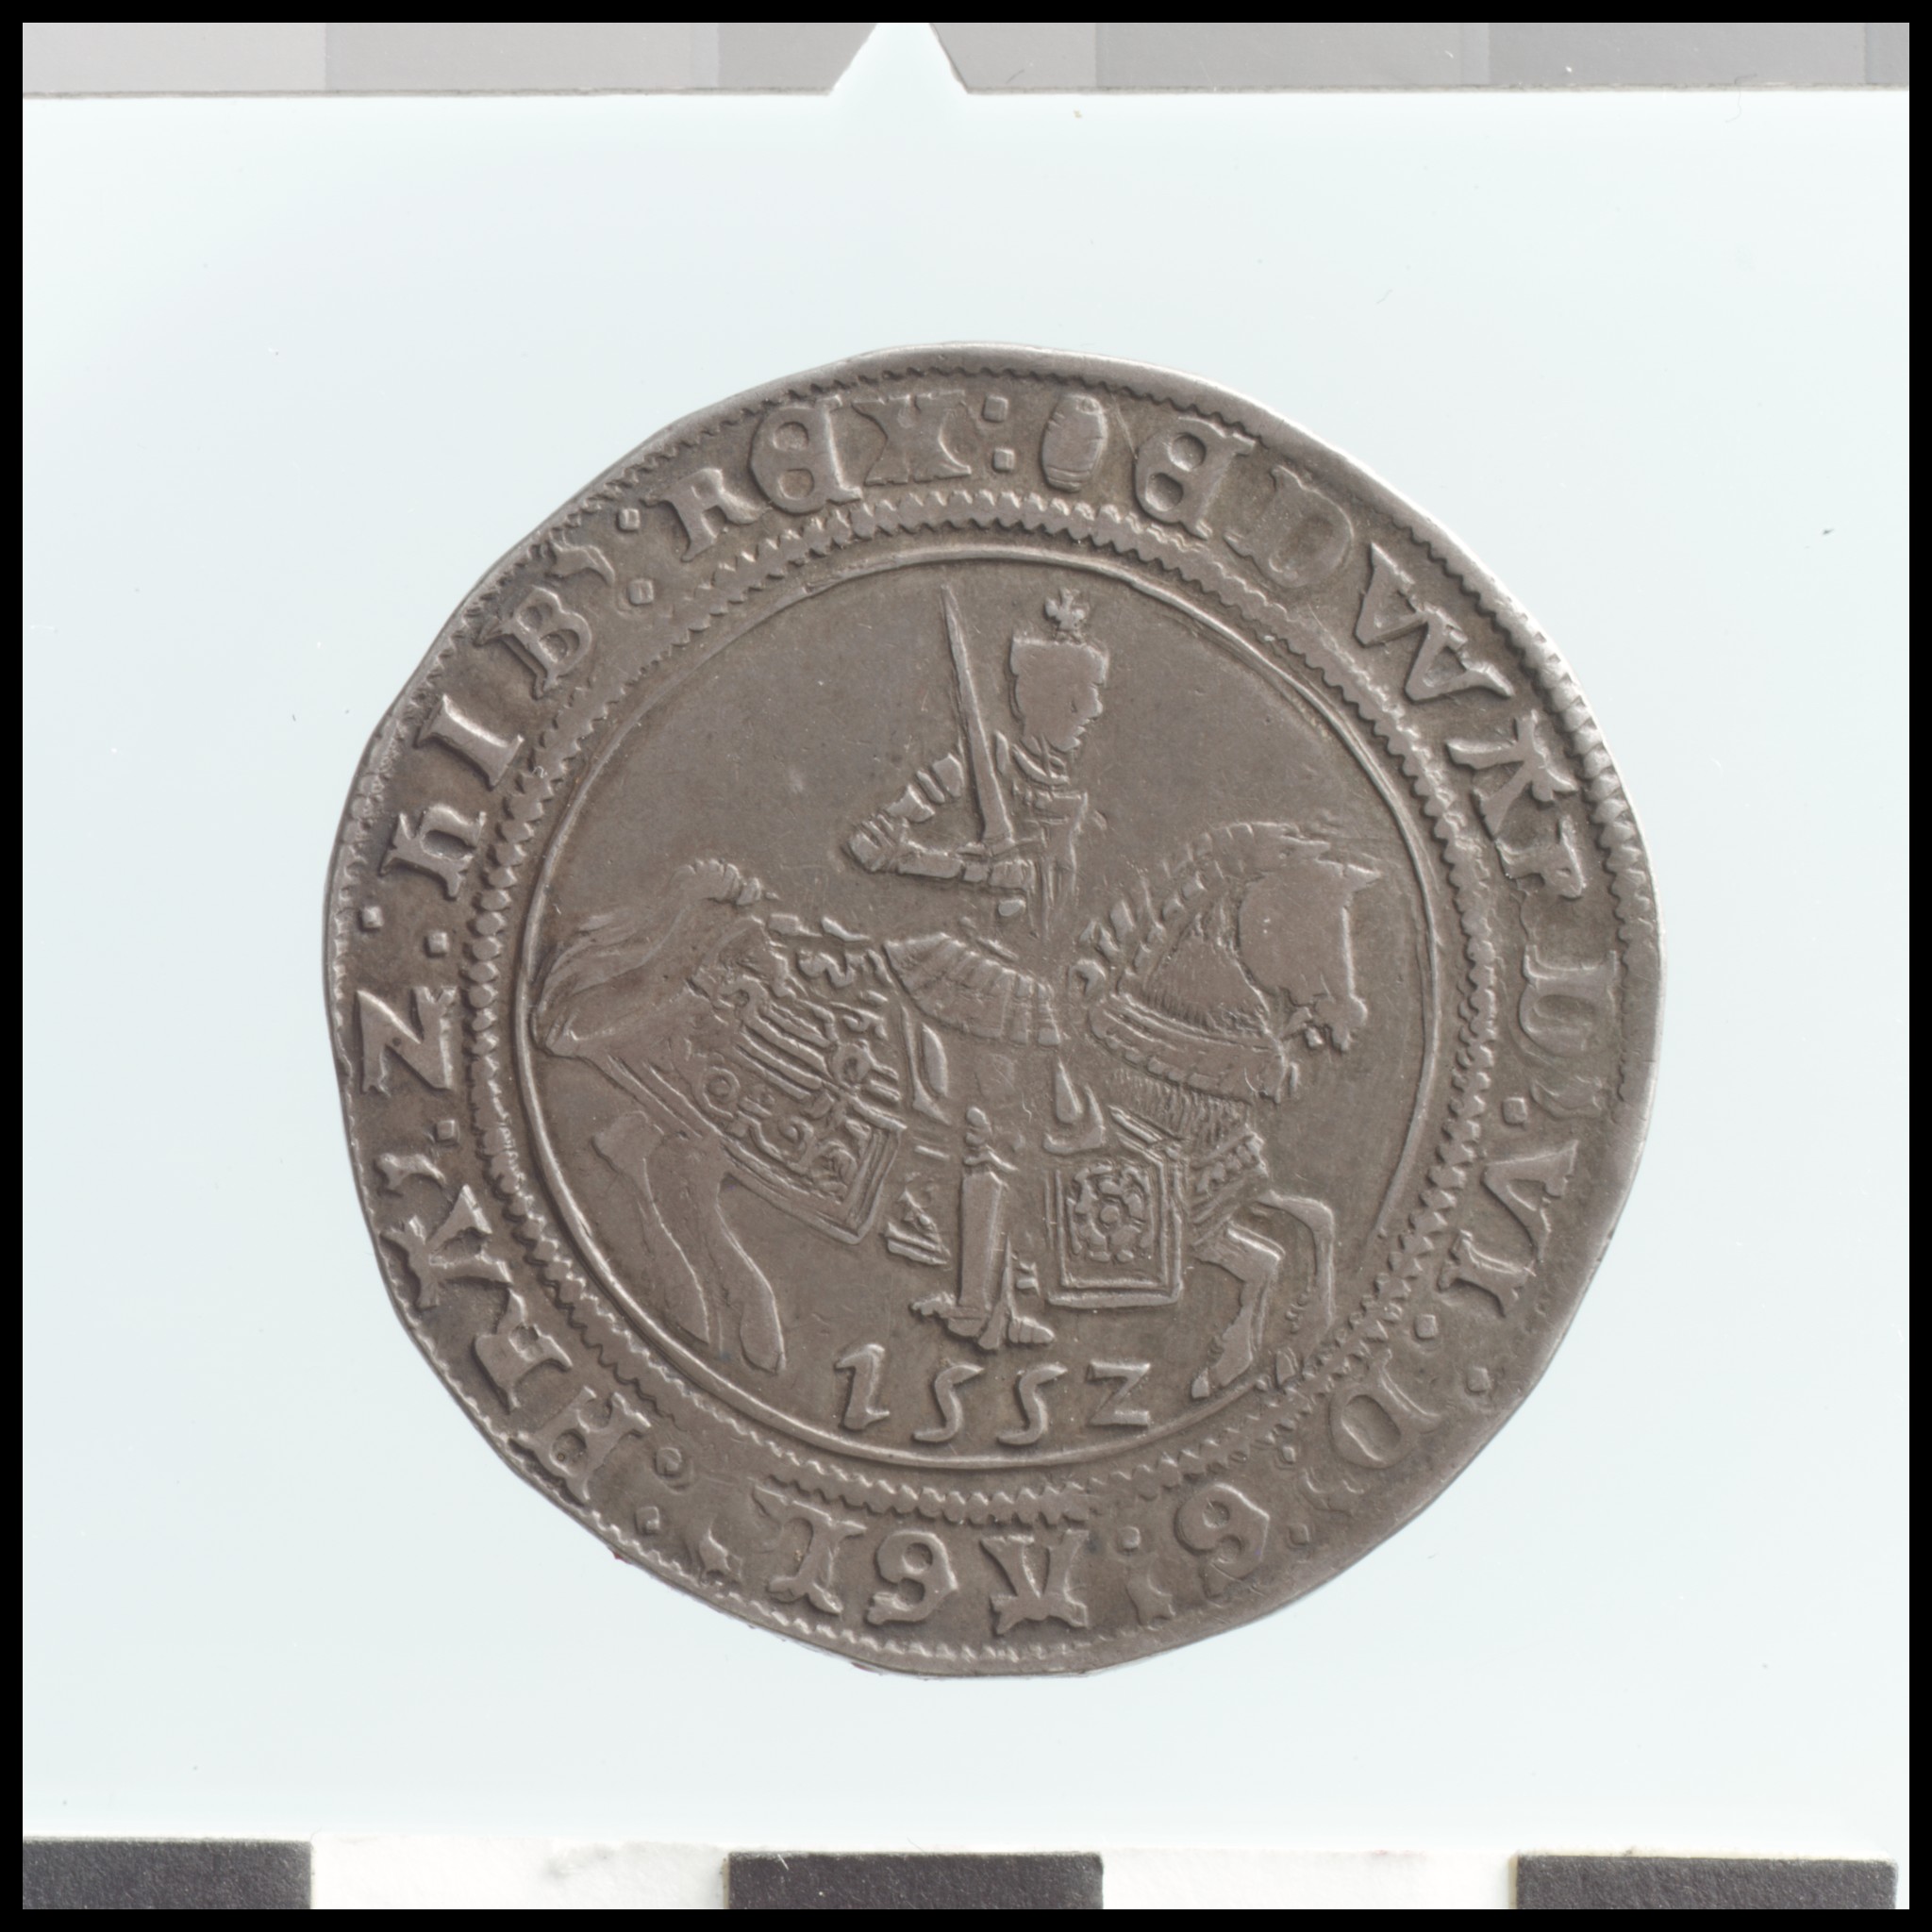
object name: half crown coin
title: Half crown of Edward VI (r. 1547–53)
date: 1552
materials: silver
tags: soldiers,swords,horses,coat of arms